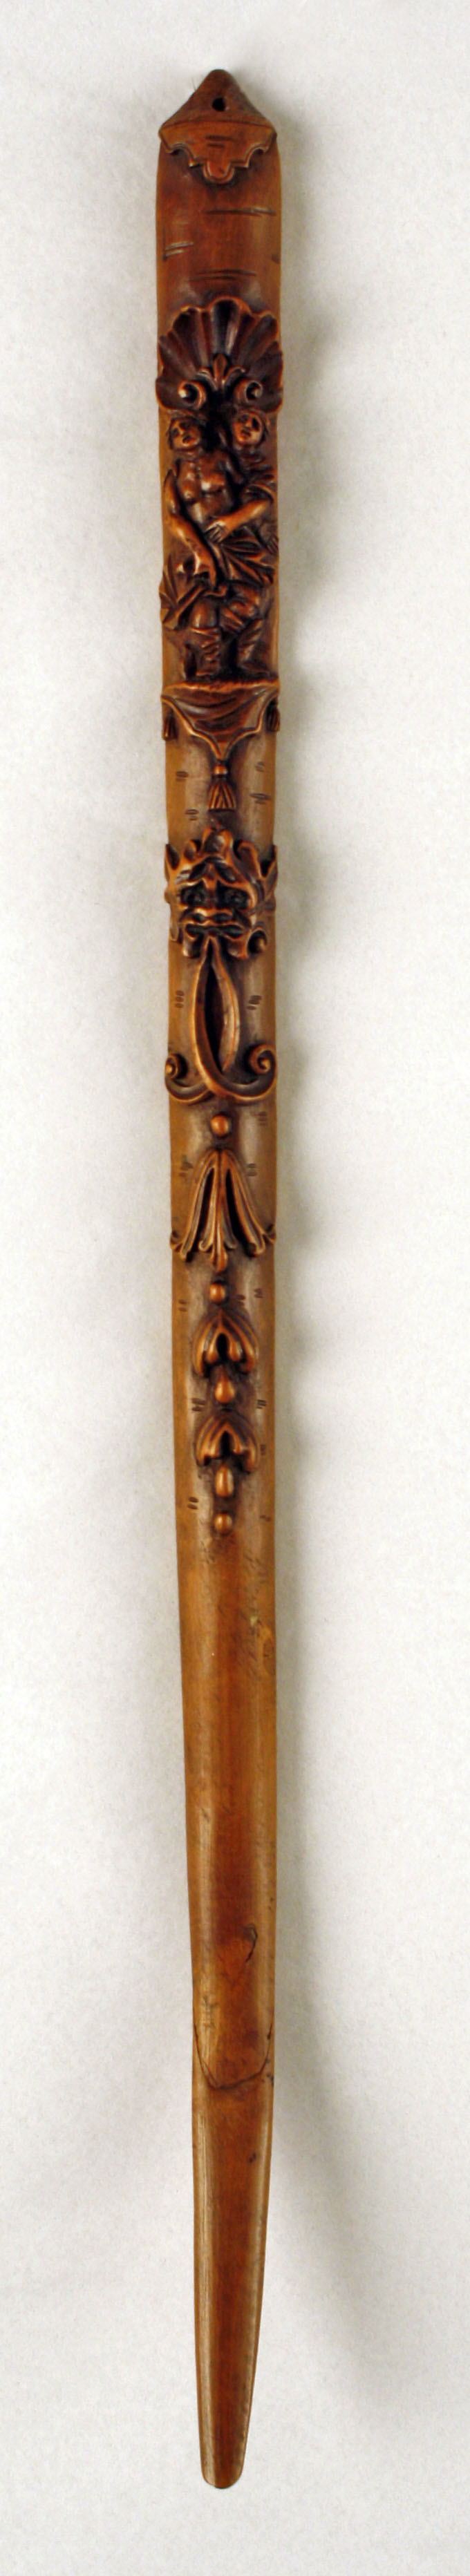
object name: busk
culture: italian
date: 1675-1725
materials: wood